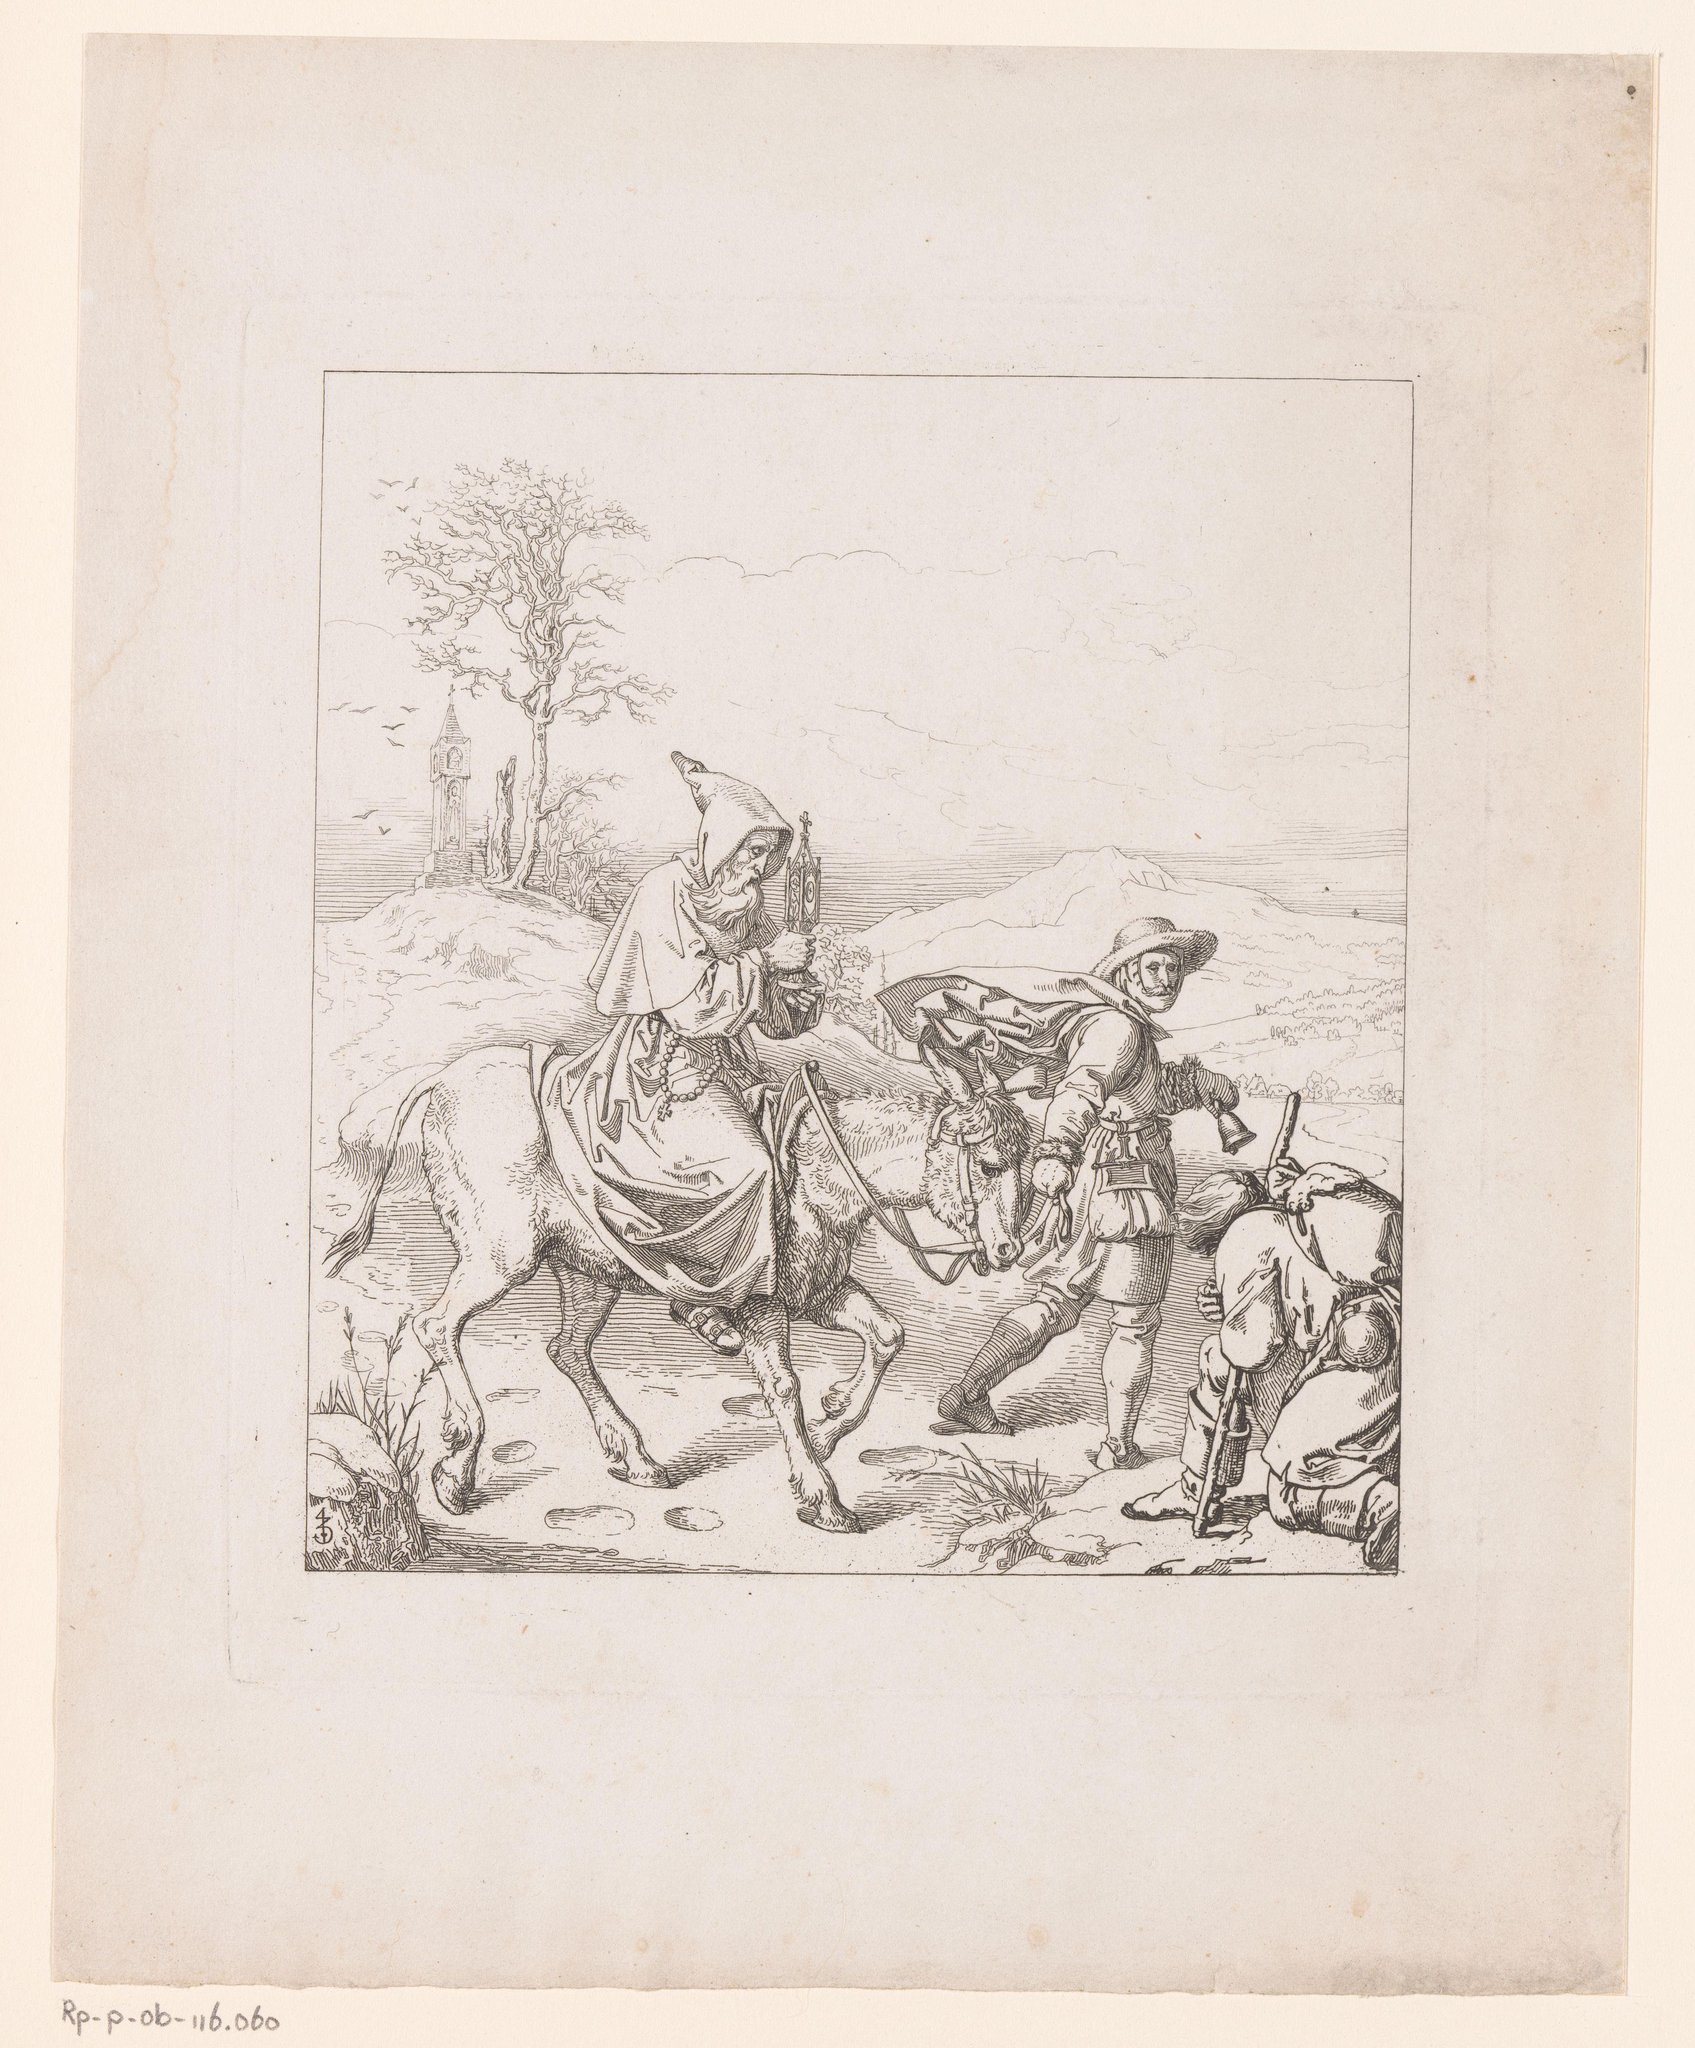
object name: book illustration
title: Monnik op een ezel wordt met monstrans in de handen voort geleid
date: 1840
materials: paper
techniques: etching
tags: bell ~ musical instruments, ostensorium, monstrance, monk(s), friar(s), kneeling figure, procession ~ christian religion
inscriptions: collector's mark: Lugt 2228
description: Prent uit: Müller, Anton en Joseph von Führich. Das Vater Unser in neun Blättern. Praag: Peter Bohmanns Erben, 1840.